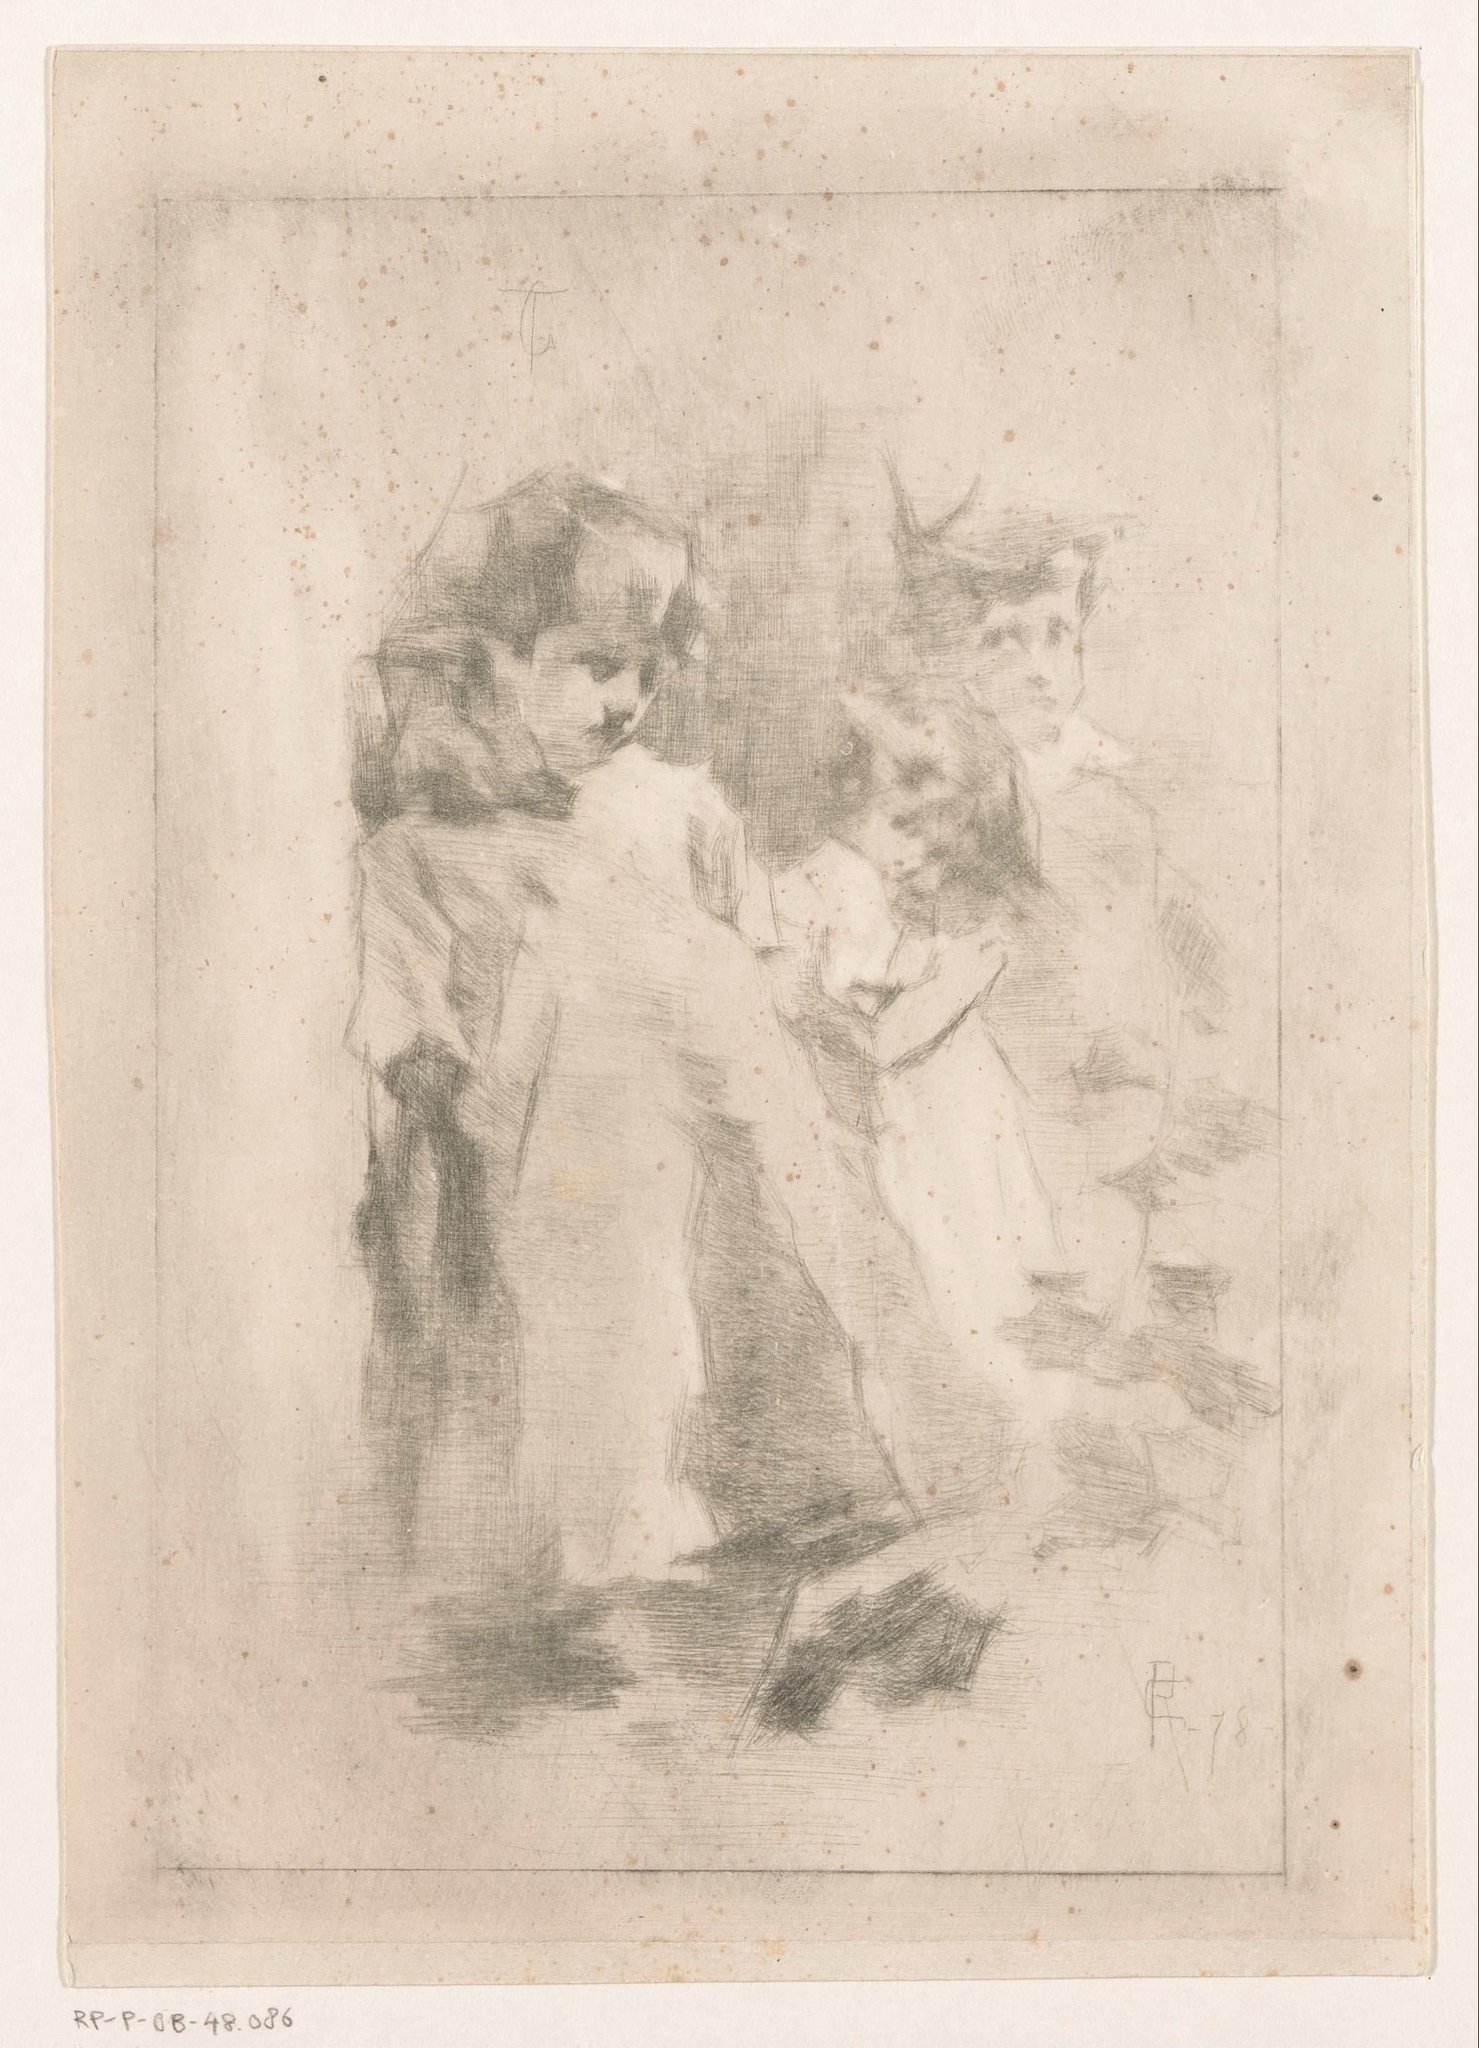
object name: print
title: Drie kinderen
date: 1878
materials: paper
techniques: etching, intaglio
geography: spain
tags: standing figure, child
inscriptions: collector's mark: Lugt 2228